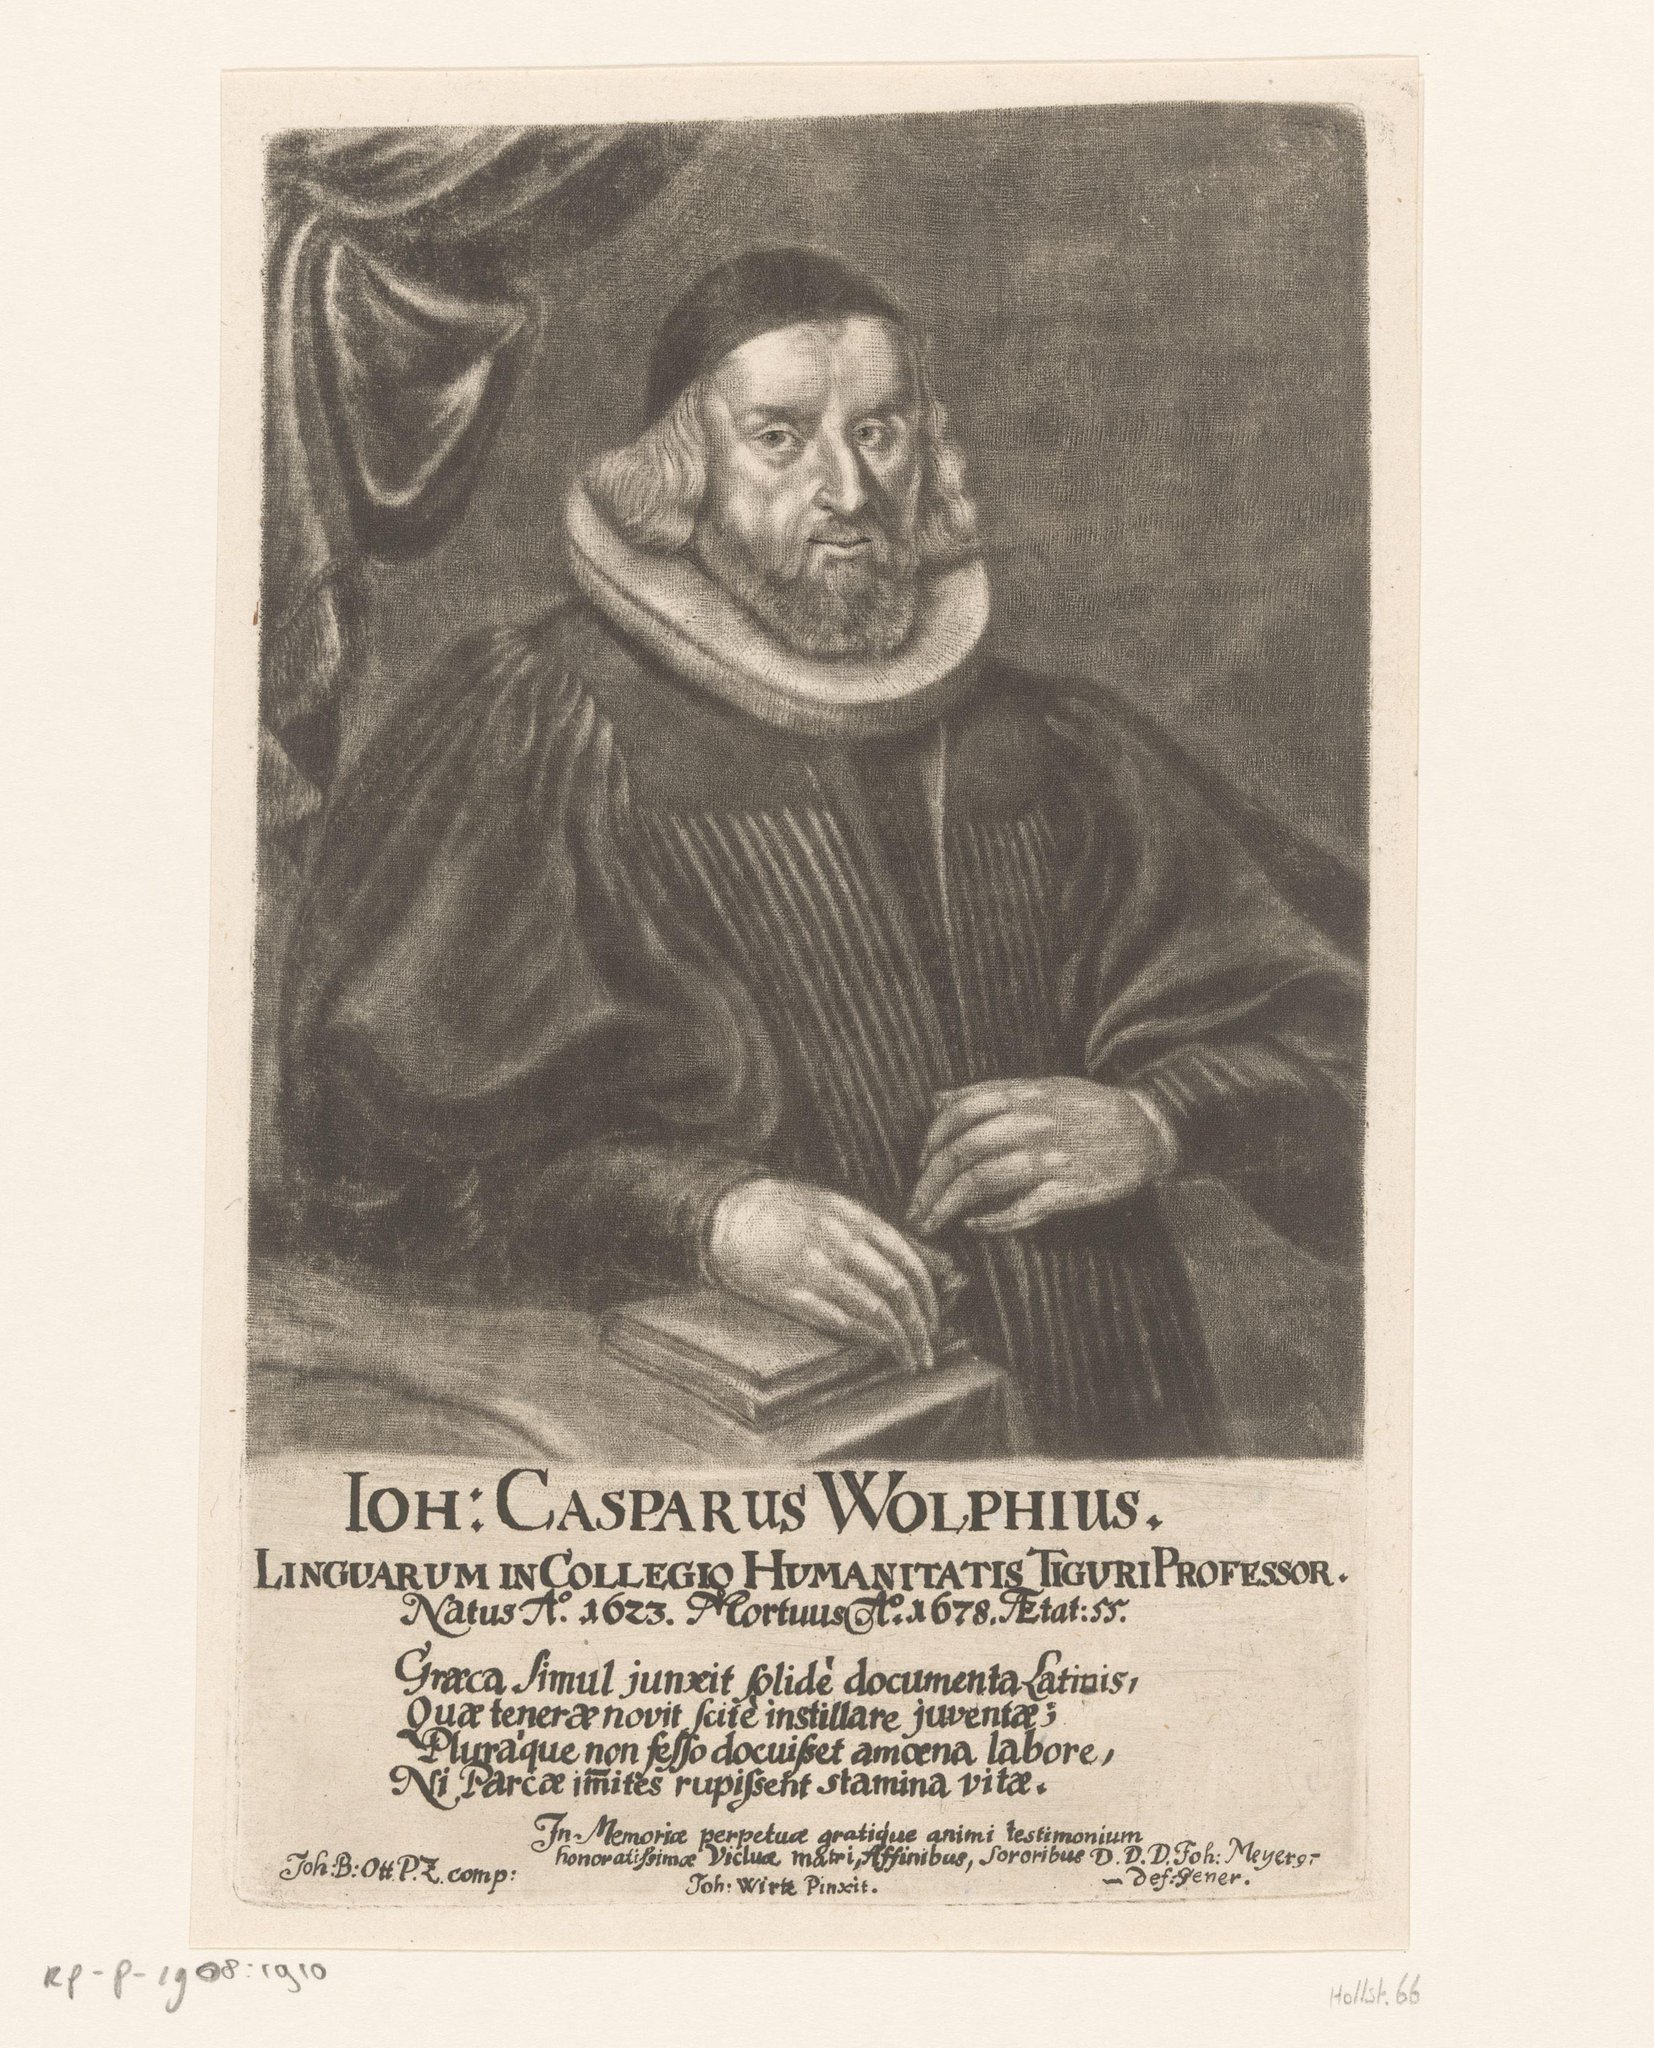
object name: print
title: Portret van Johann Caspar Wolf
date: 1678-1712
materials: paper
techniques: mezzotint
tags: historical persons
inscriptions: collector's mark: Lugt 2228